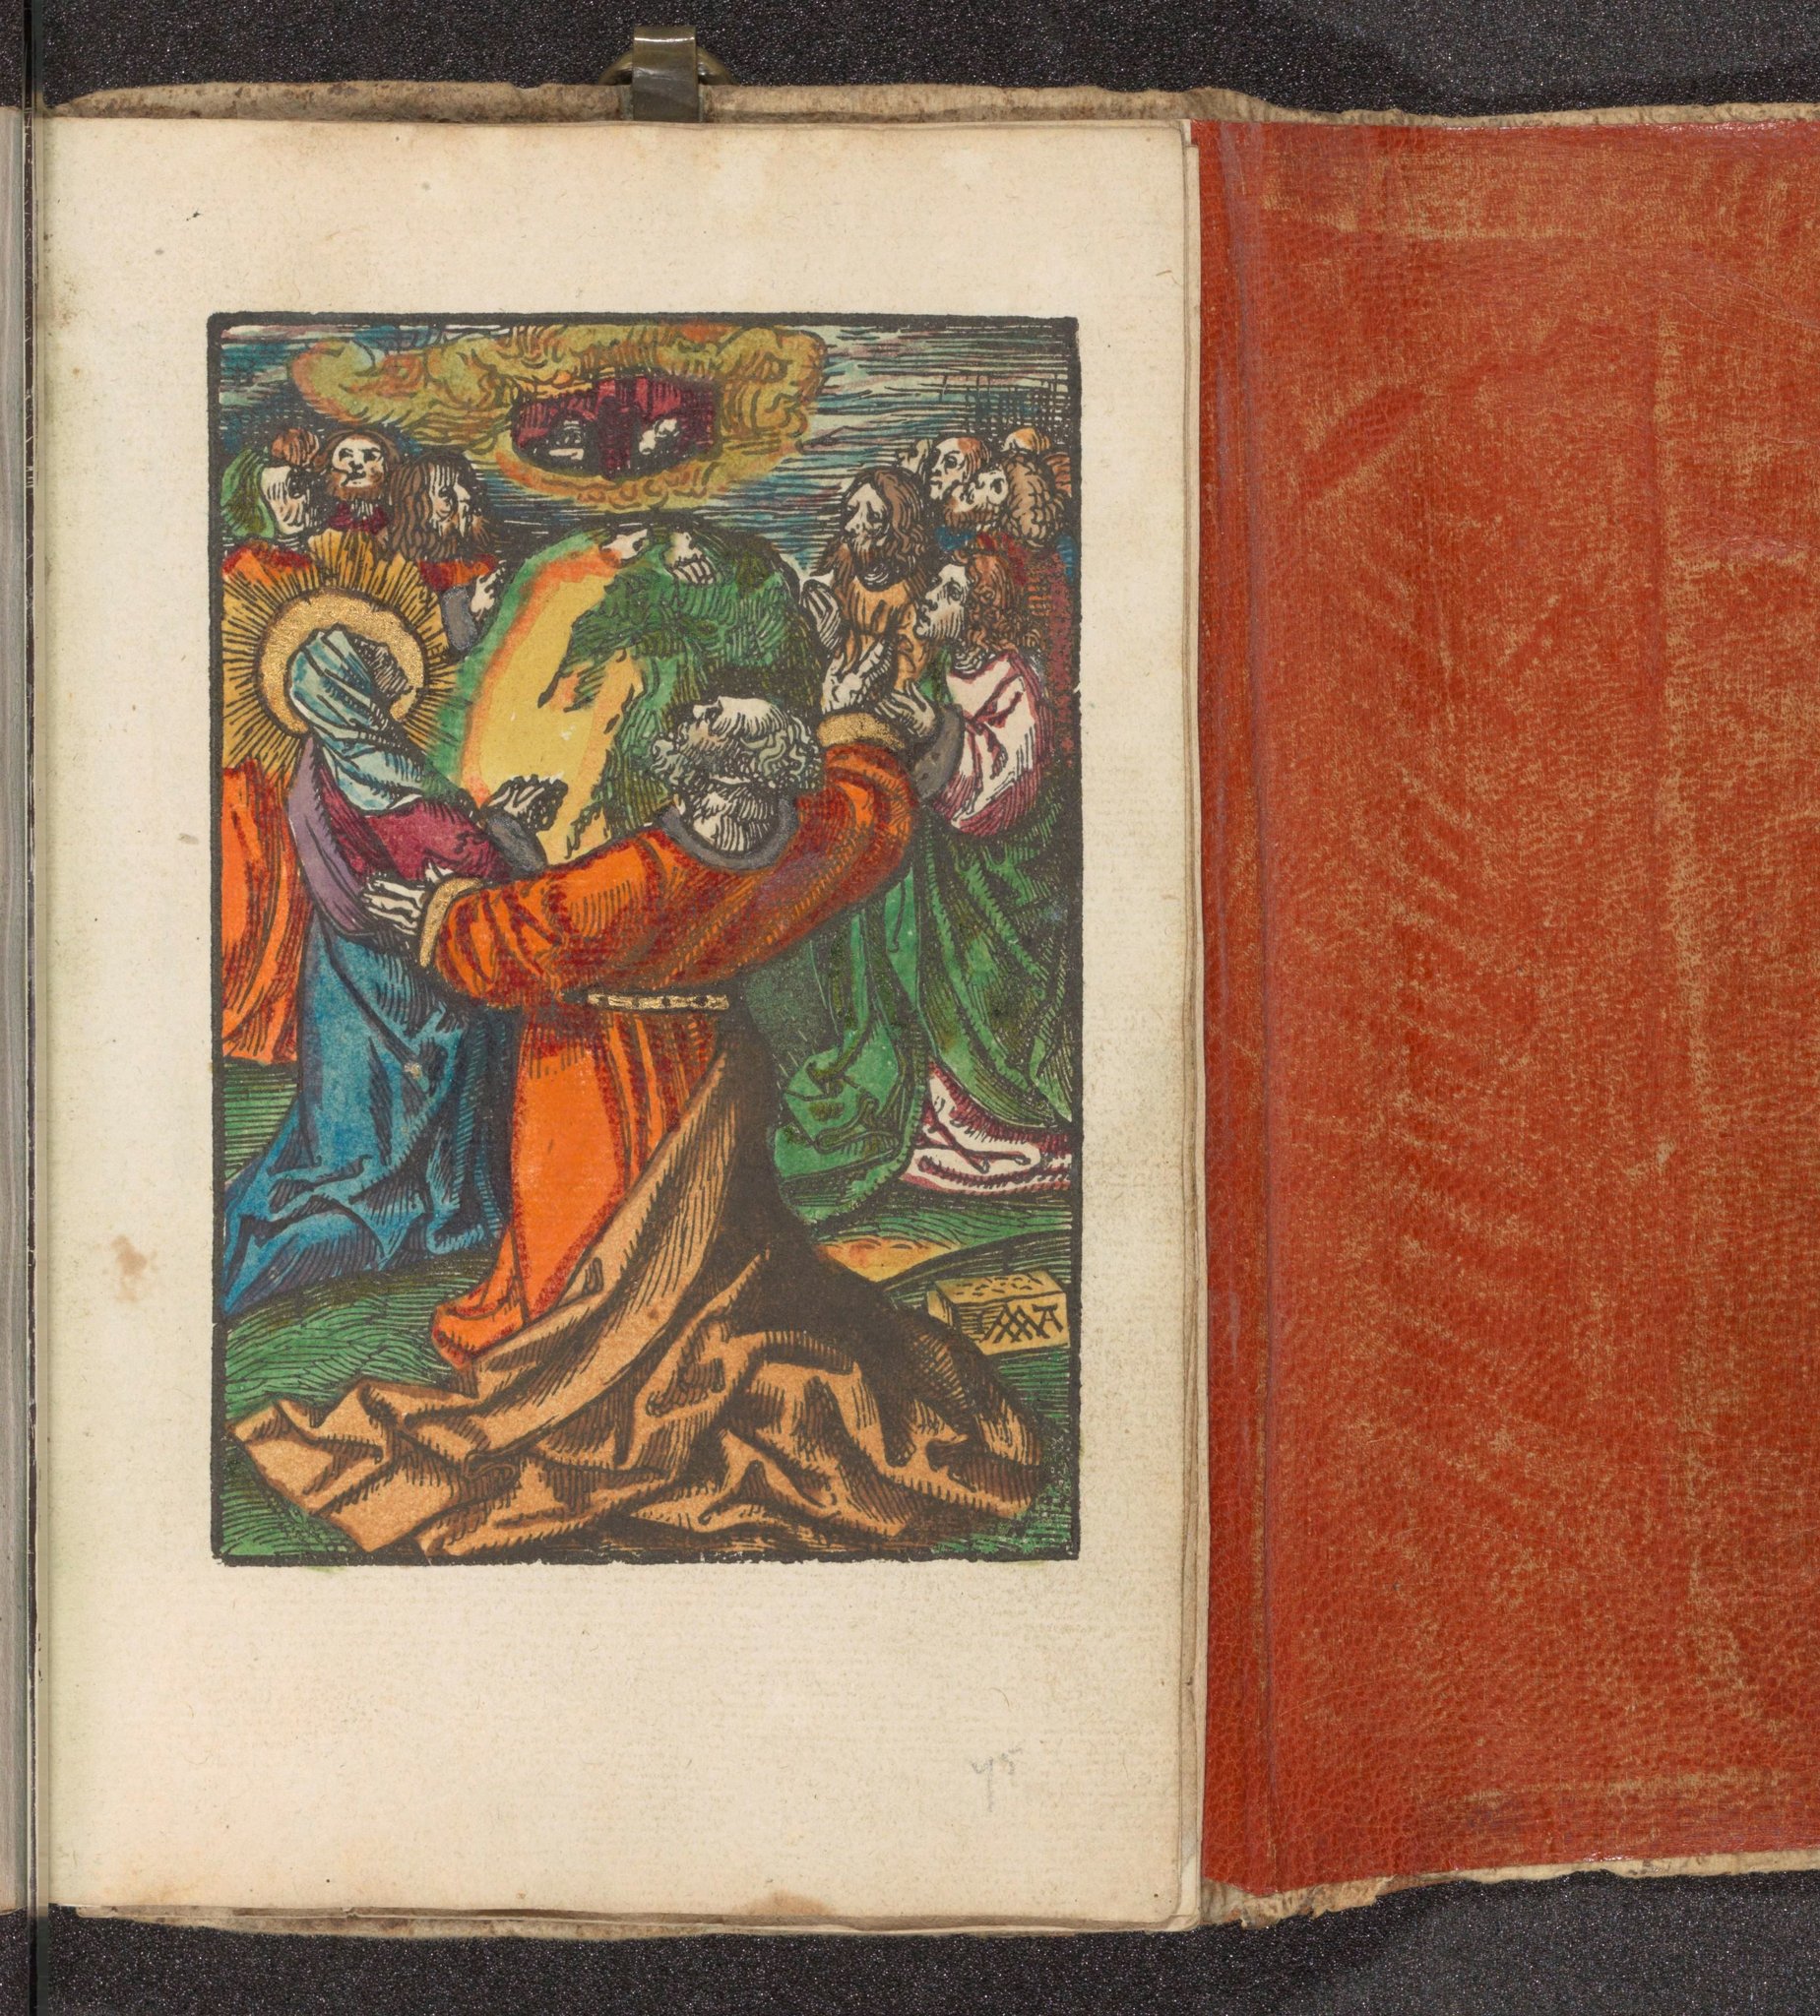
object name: print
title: De kleine Passie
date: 1520-1521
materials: paper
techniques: hand coloring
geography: amsterdam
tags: book in which illustrations are essential, christ almost vanished: only feet visible ~ ascension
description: Hemelvaart van Christus. De apostelen (Petrus op de rug gezien) en Maria blijven op de berg achter en zien Christus opstijgen naar de hemel. Prent maakt deel uit van een boek.